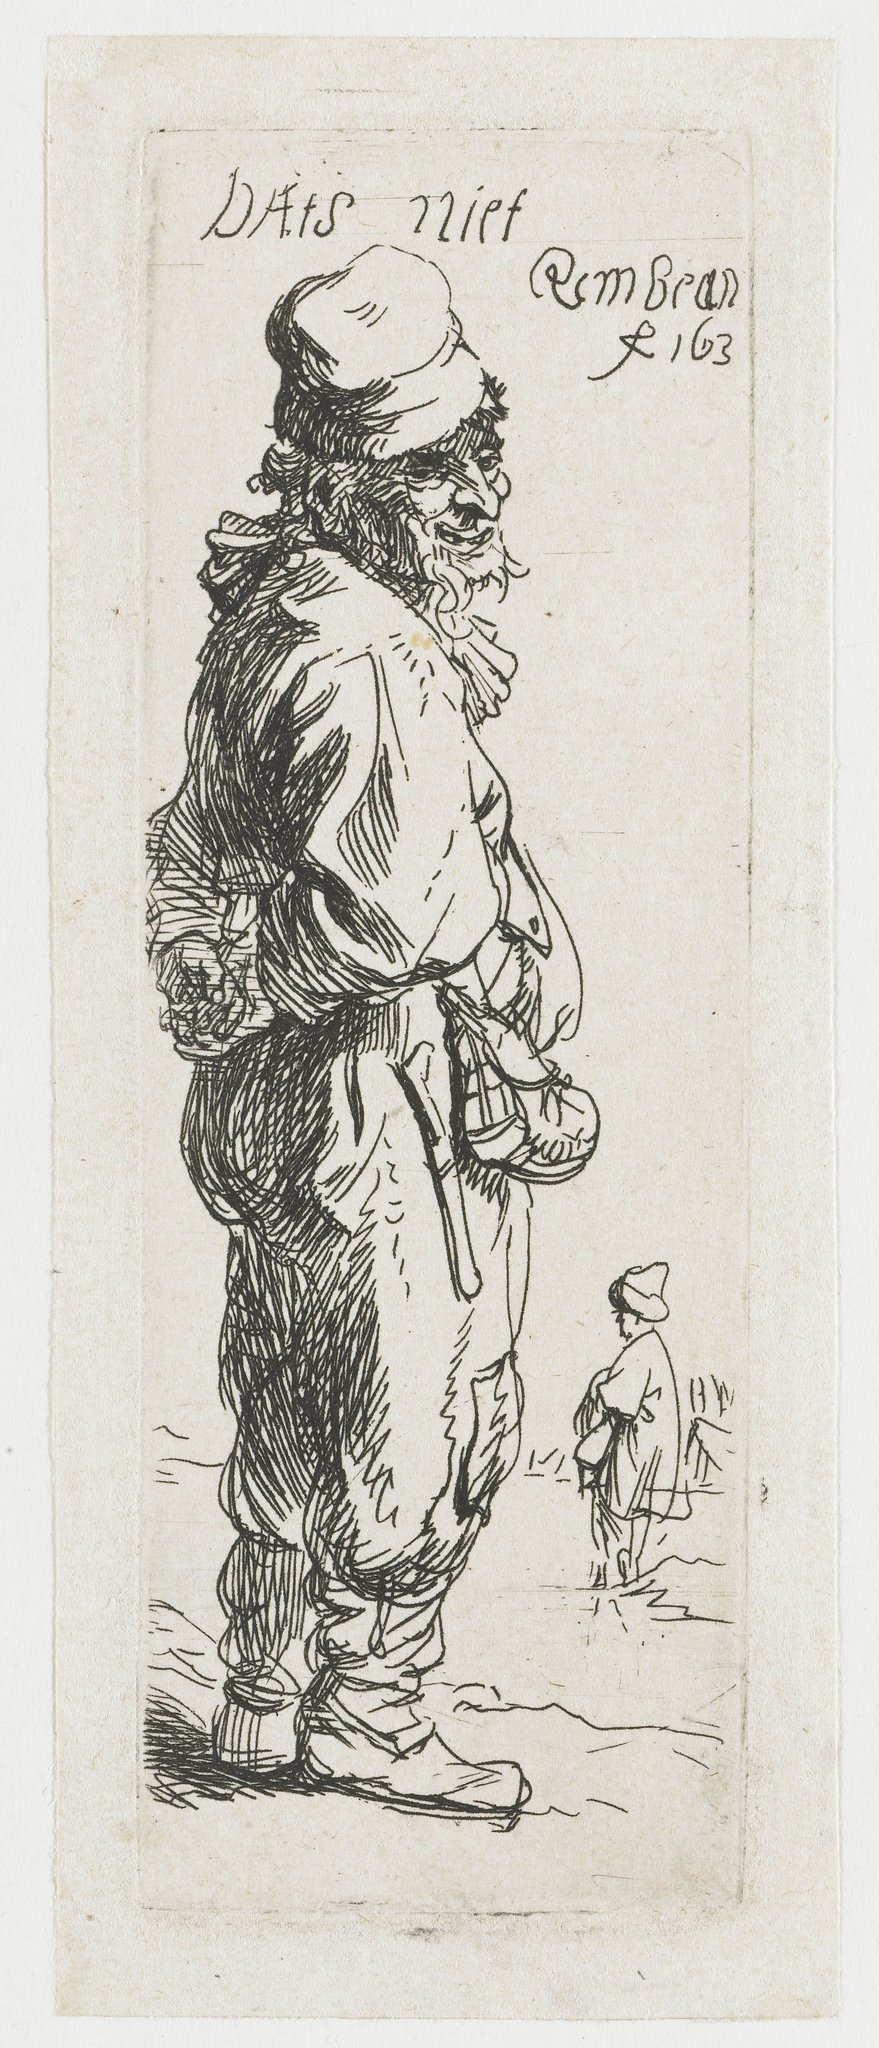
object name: print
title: A peasant replying 'Dats niet'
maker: rembrandt van rijn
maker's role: draughtsman, painter, print maker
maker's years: 1606-1669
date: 1634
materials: paper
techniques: etching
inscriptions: collector's mark: Lugt 240, signature and date: ‘Rembran f 163’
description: Rembrandt almost certainly did not see these men in reality. He is actually responding to two peasants engraved a century earlier by the German artist Sebald Beham. One of them complains about the cold, while the other could care less. Unlike Beham’s grump, that by Rembrandt looks crotchety, while his cheerful man is laughing.